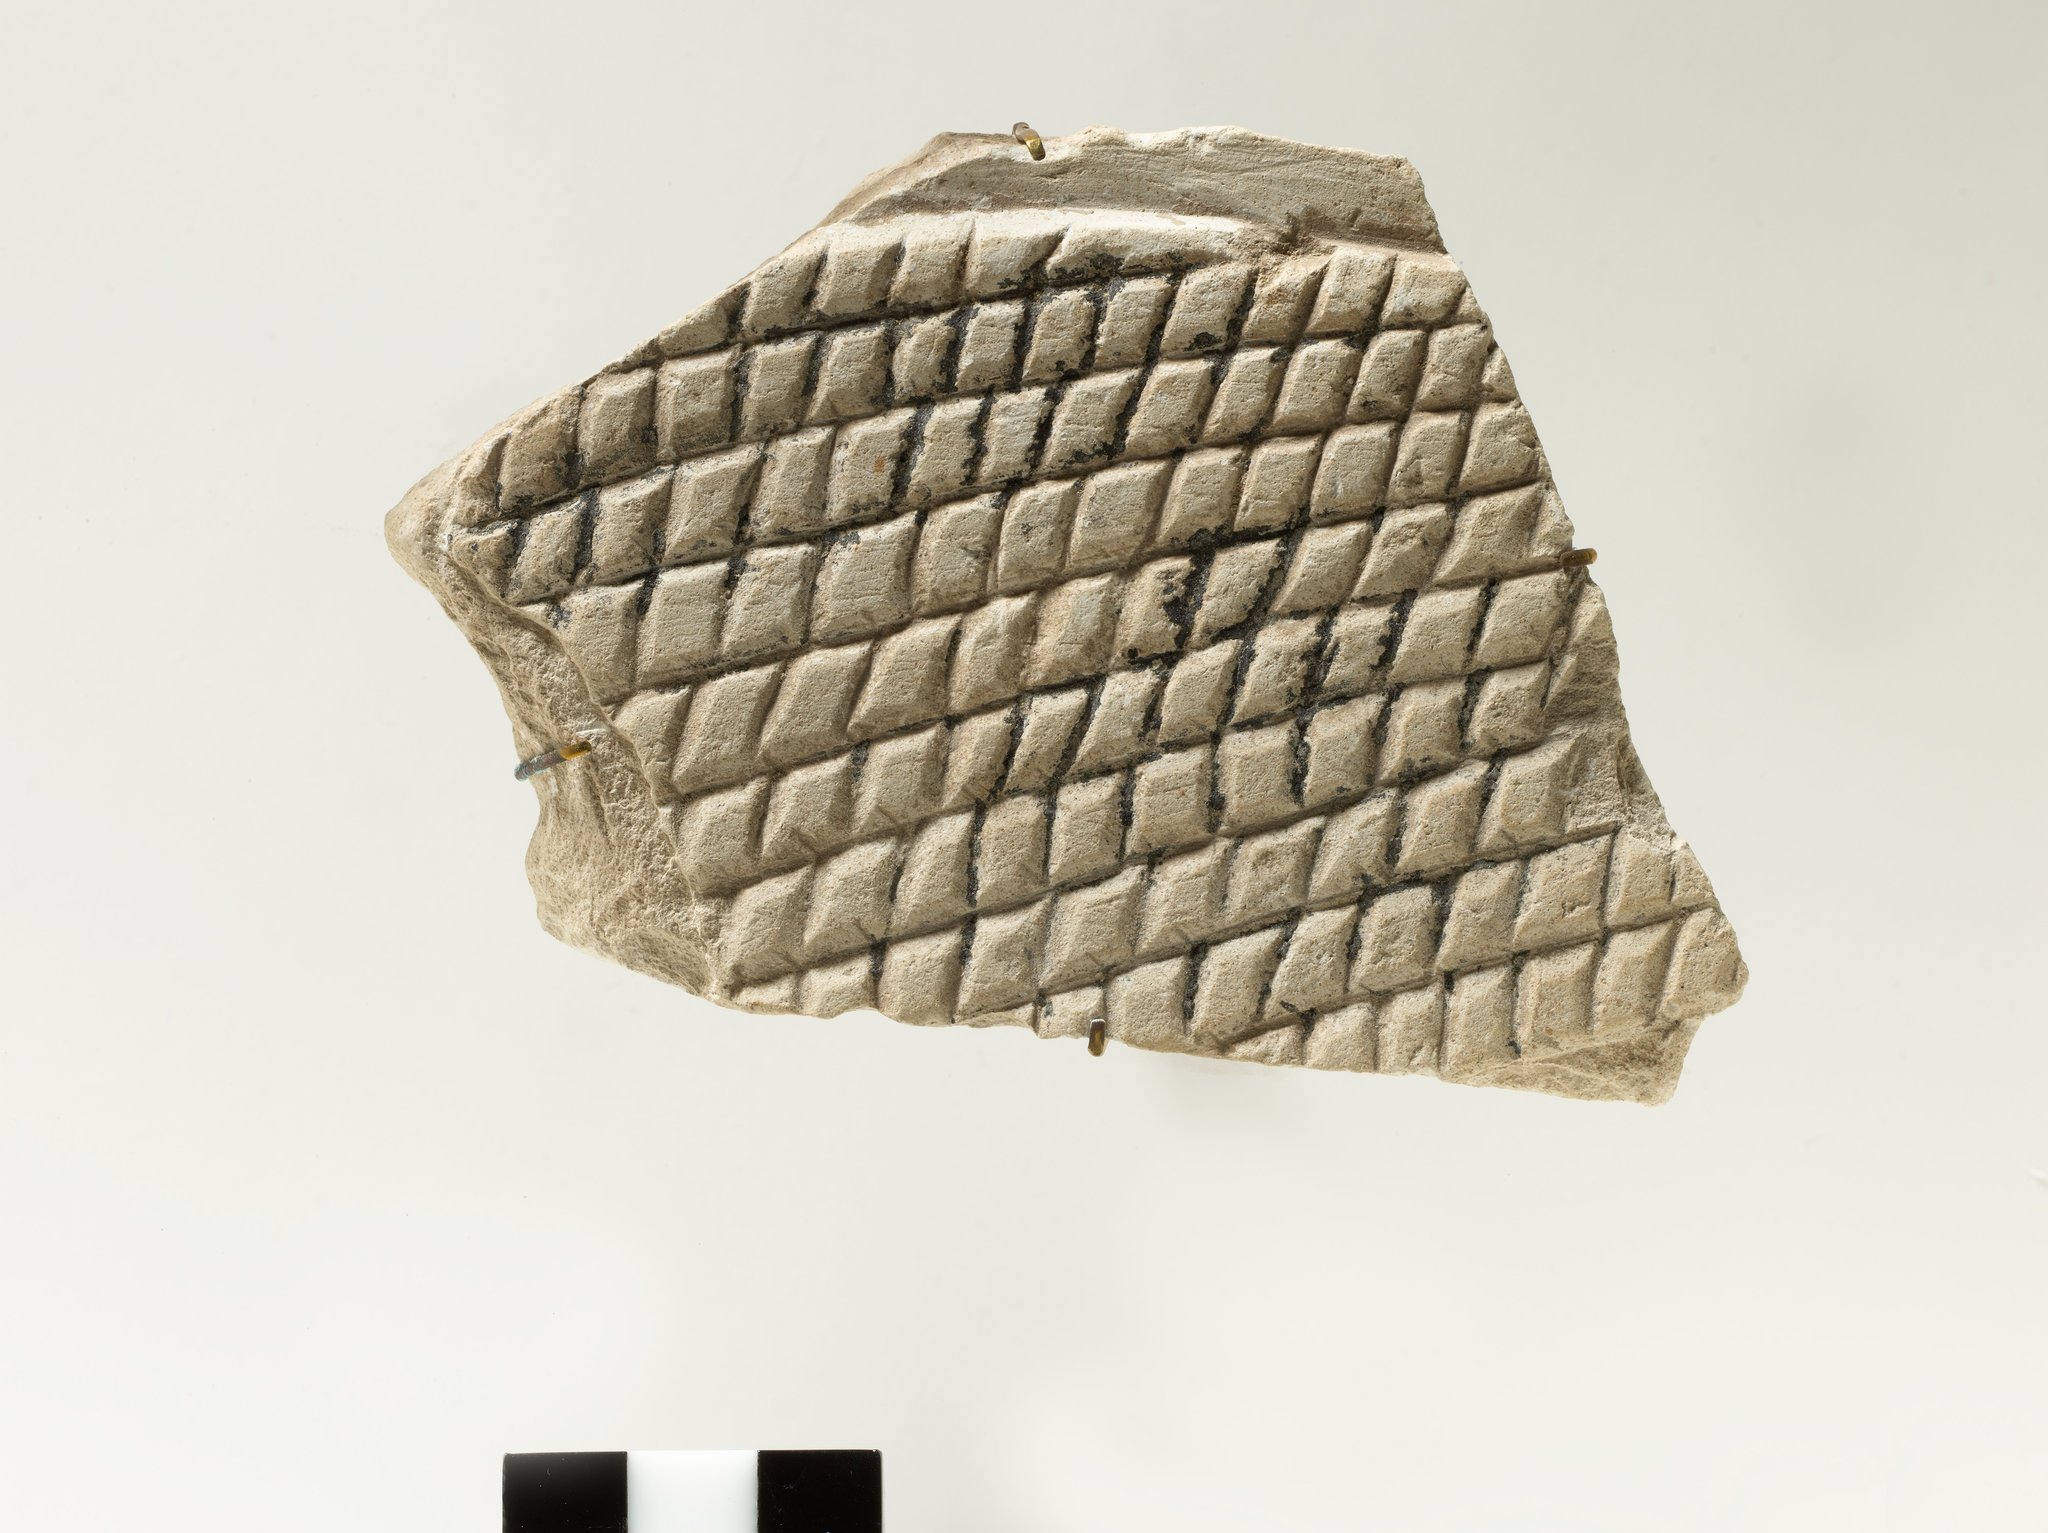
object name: relief fragment, tomb of meketre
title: Reliefs from the tomb of Meketre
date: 1981-1975 BCE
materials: limestone, paint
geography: egypt